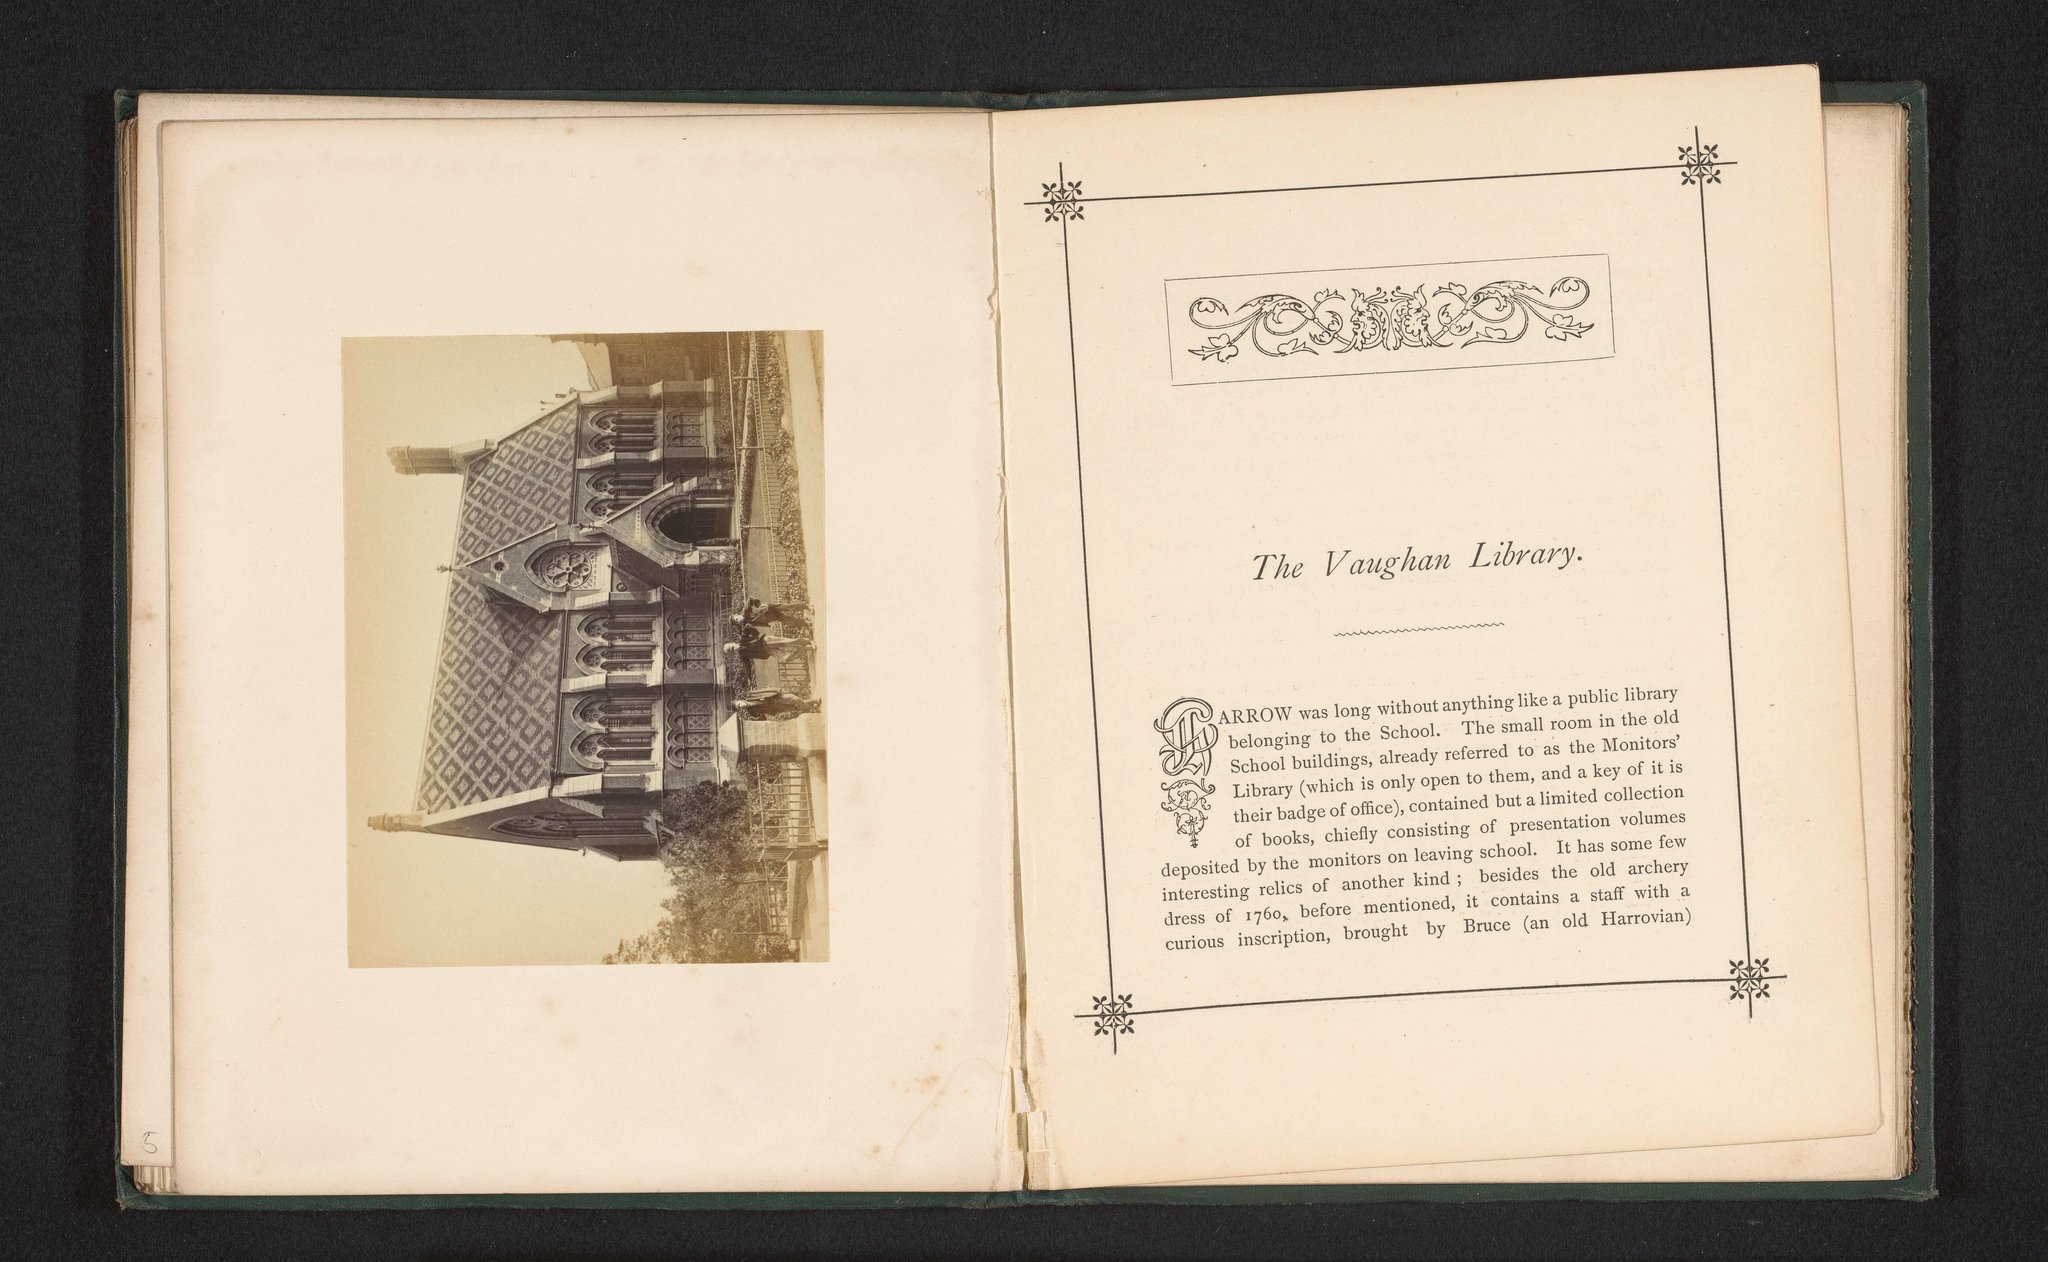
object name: page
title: Exterieur van de bibliotheek van Harrow School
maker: william russell sedgfield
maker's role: fotograaf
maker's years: 1826-1902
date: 1860-1870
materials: photographic support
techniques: albumen print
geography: harrow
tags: façade (of house or building), public library